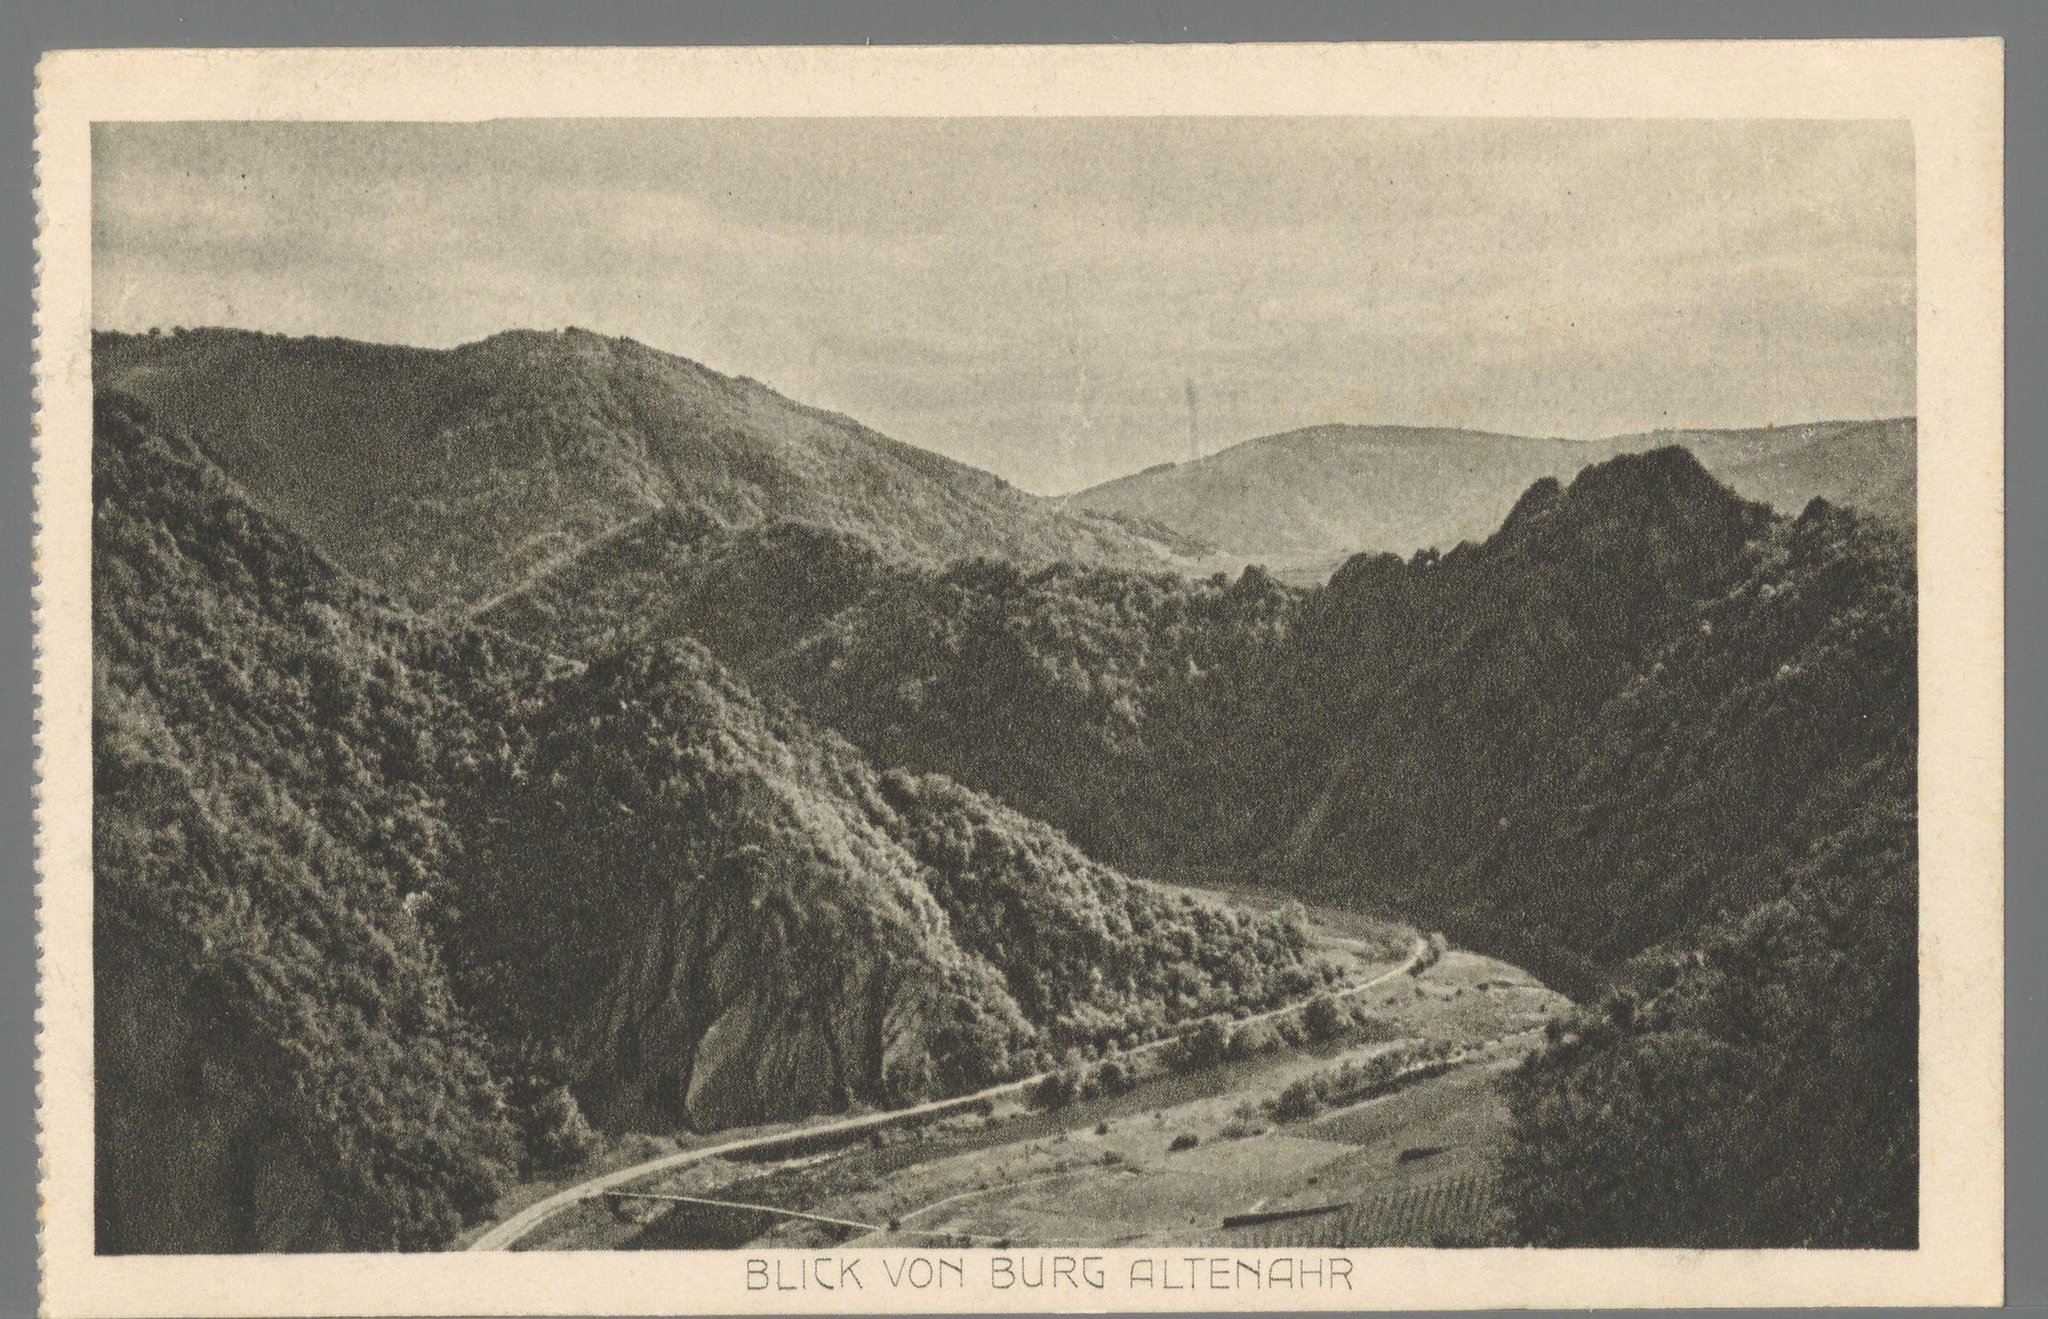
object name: ansichtkaart, prentbriefkaart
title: Blick von Burg Altenahr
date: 1905-1930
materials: cardboard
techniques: rotogravure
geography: ahrweiler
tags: mountains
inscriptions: monogram: ‘K.T.F.’